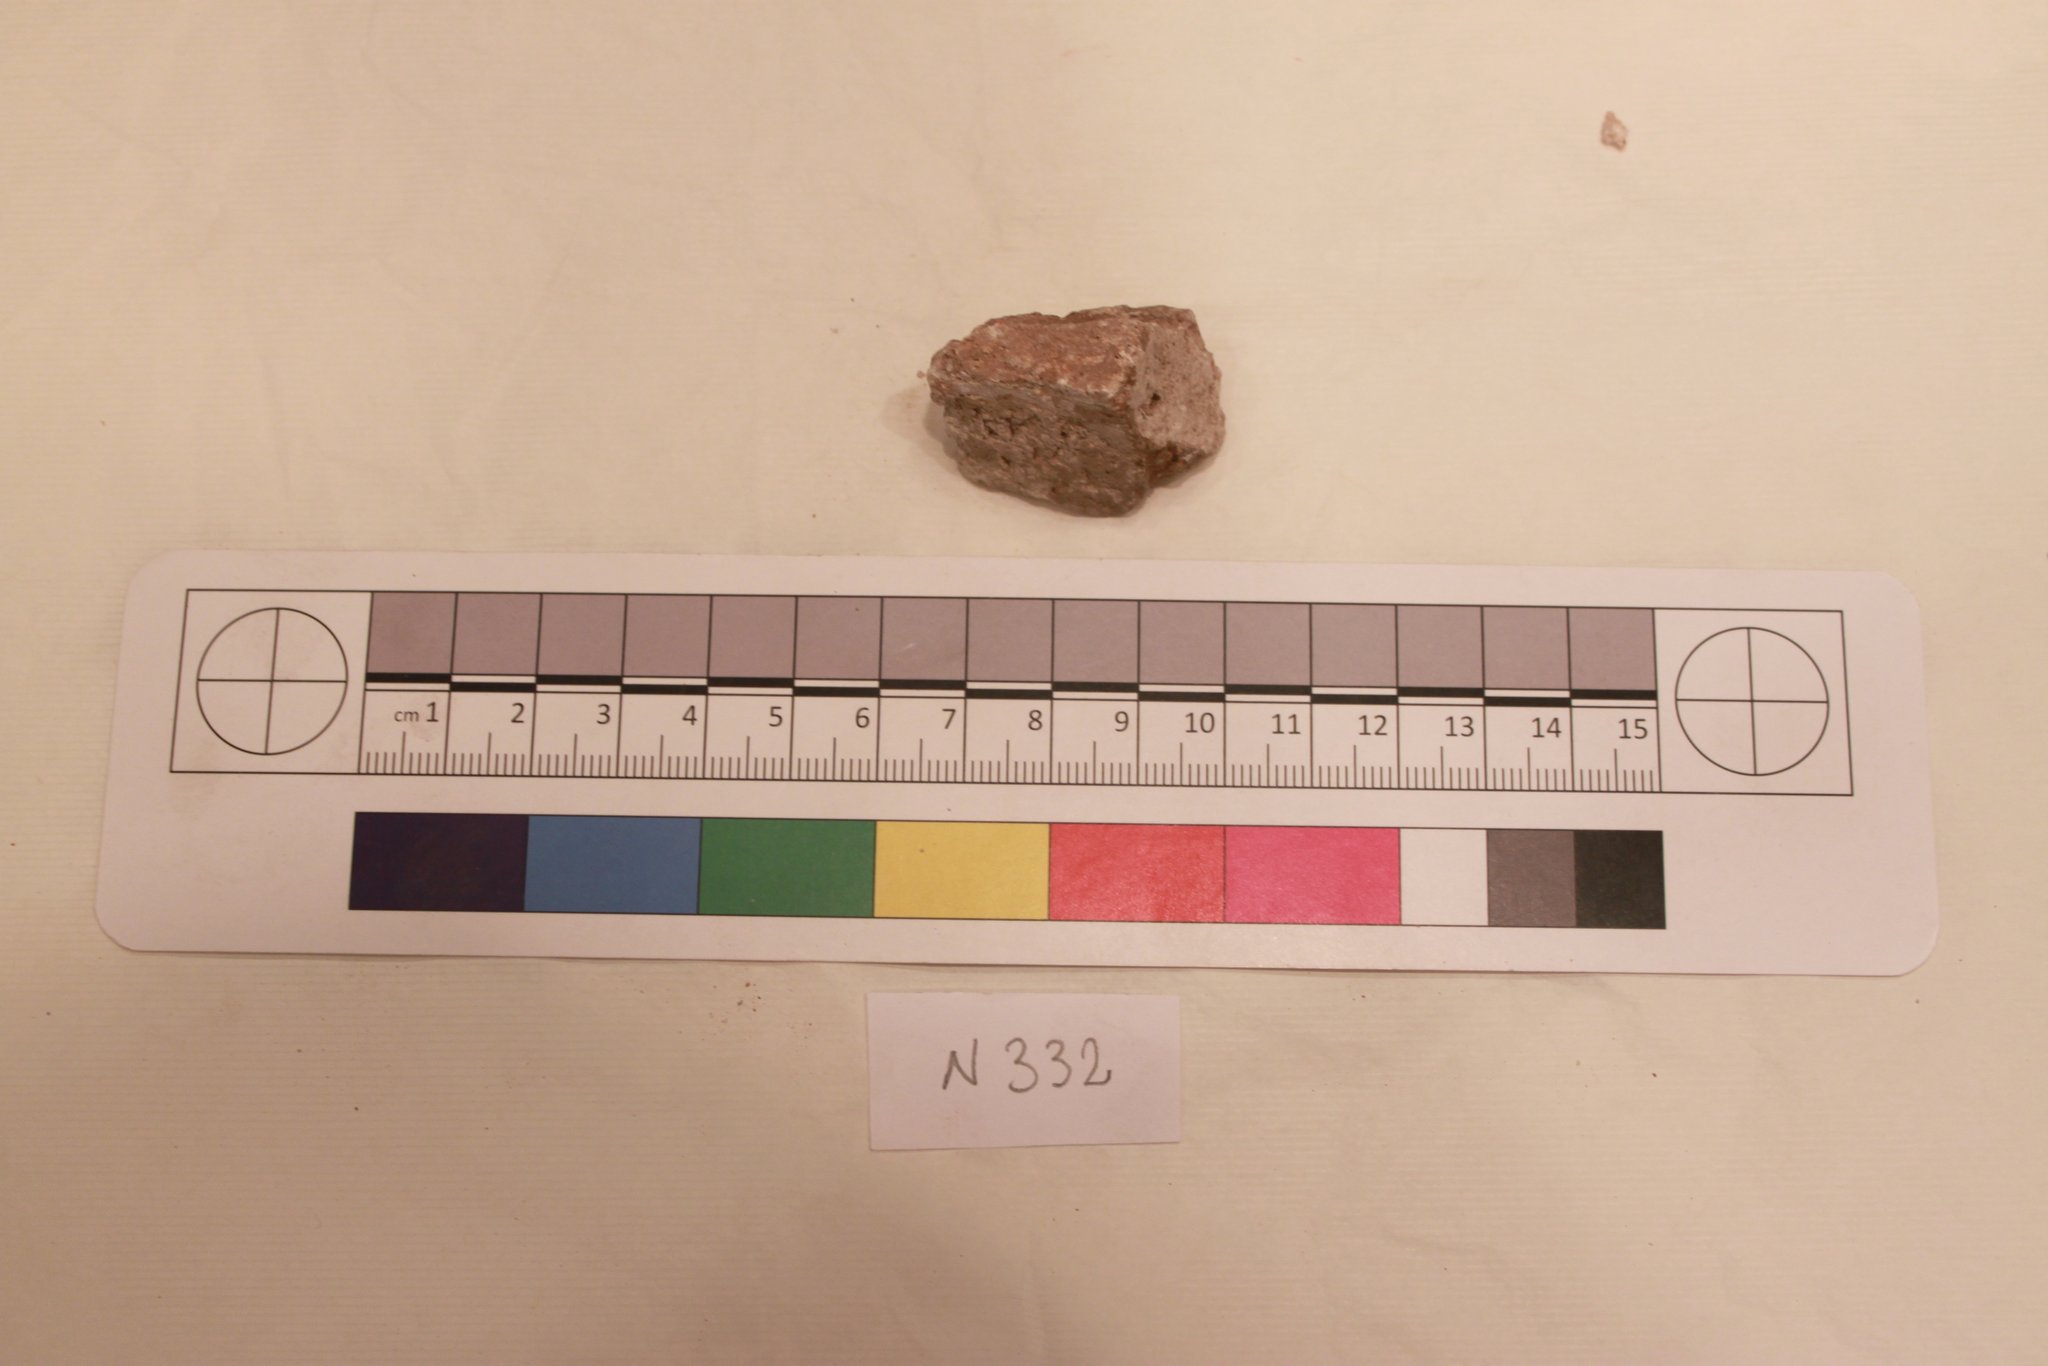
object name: fragment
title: Stucco Fragment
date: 701-1200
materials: plaster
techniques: carving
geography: iran